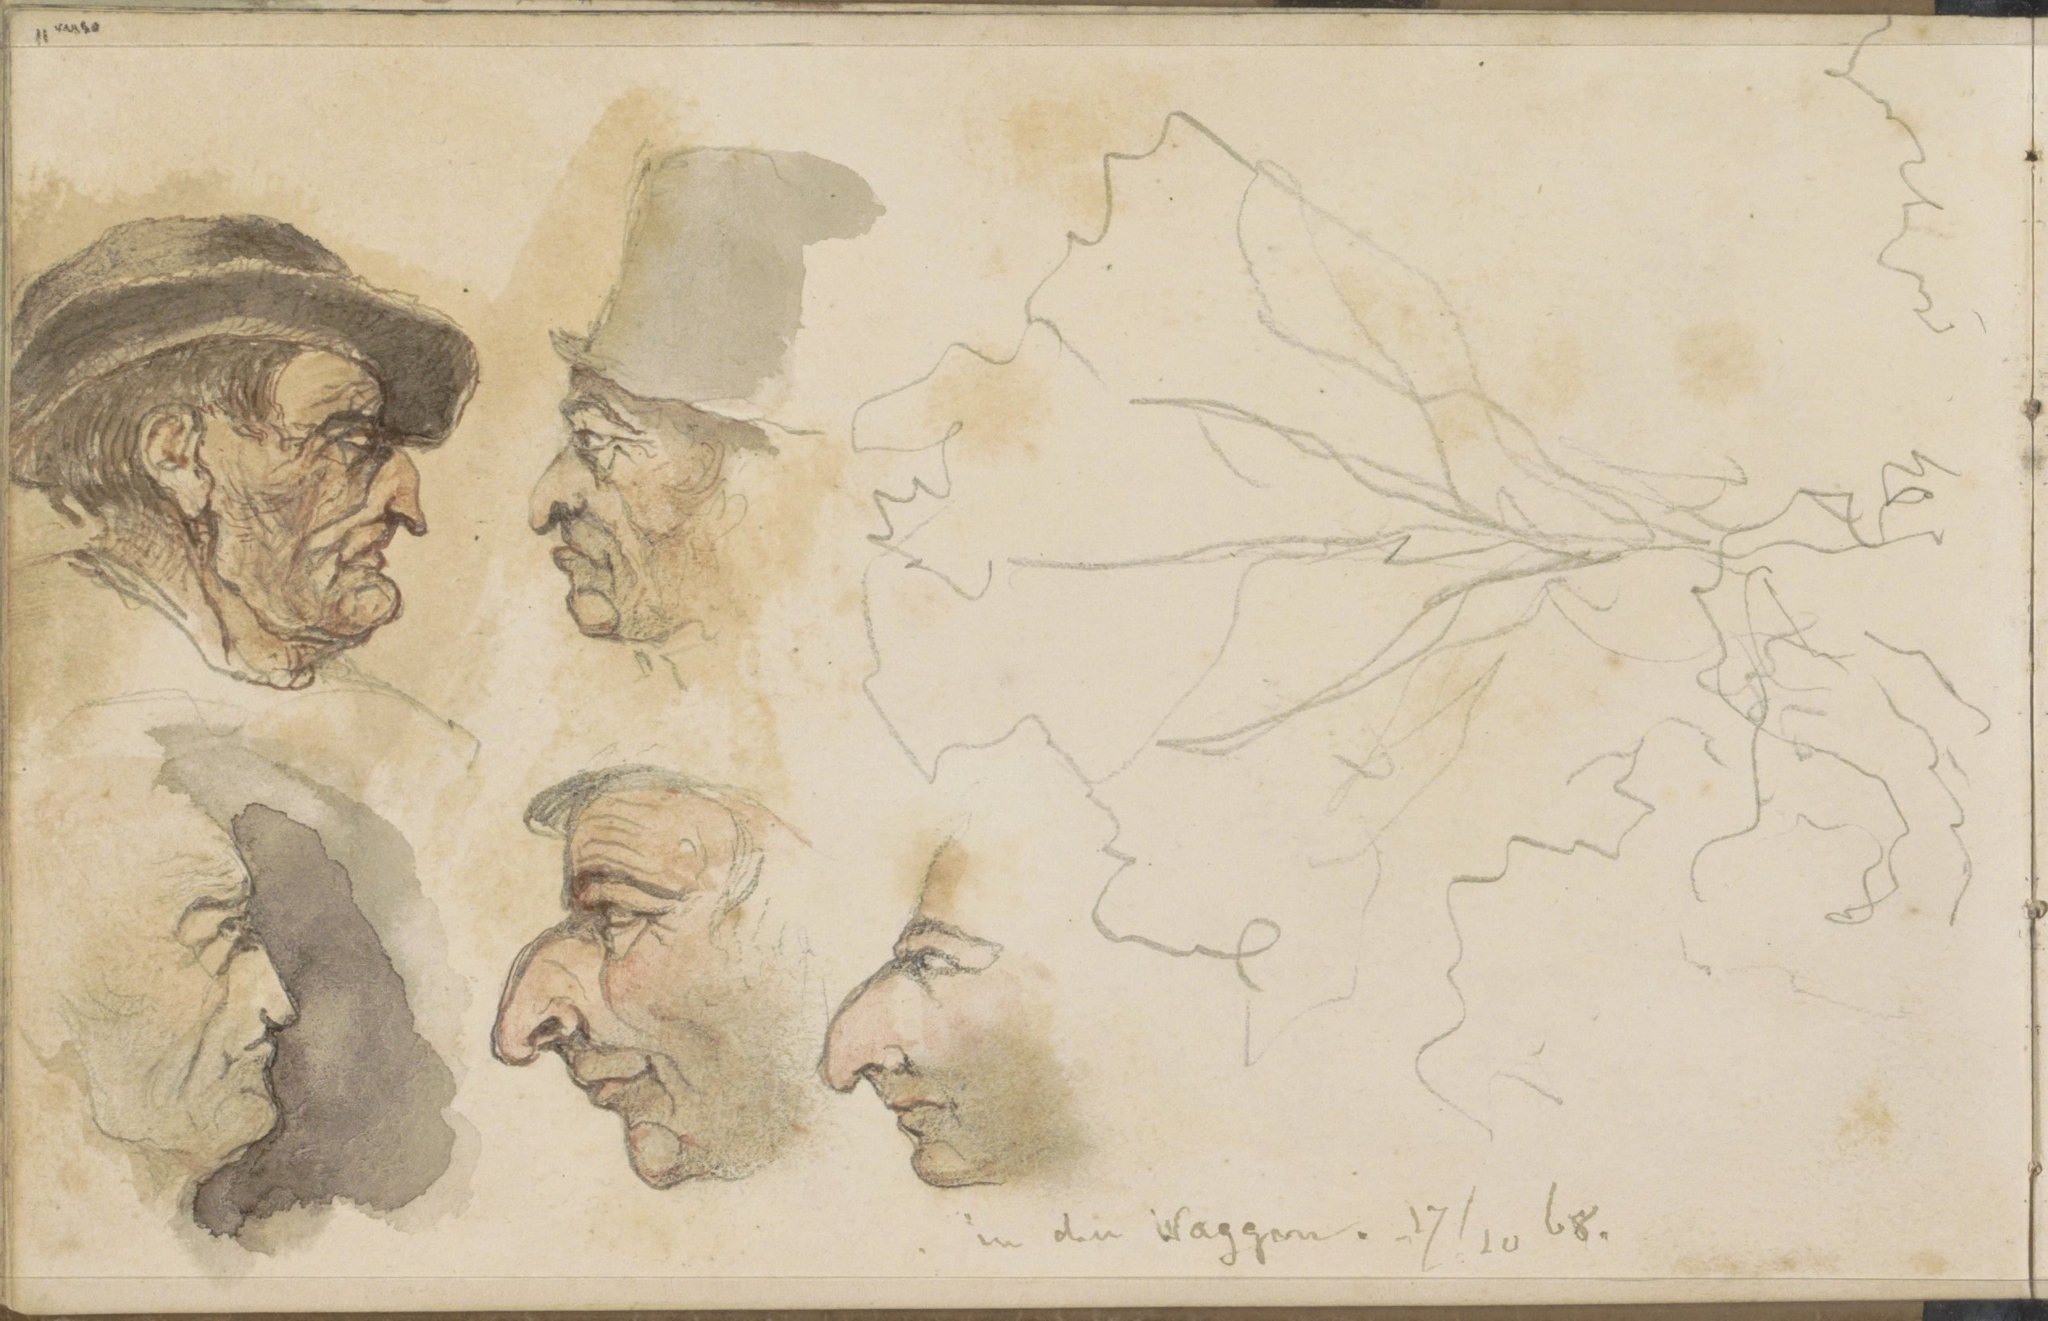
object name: sketchbook leaf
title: Koppen van mannen met haakneuzen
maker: johannes tavenraat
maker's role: draughtsman, painter, print maker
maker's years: 1809-1881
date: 1810-1868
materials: ink, paper, pencil, watercolor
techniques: brush, pen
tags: head (human), adult man, head-gear: hat (+ men's clothes)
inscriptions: date and inscription: ‘in den wagg[...] 17/10 68.’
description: Tevens een studie van een boom. Blad 11 verso uit een schetsboek met 48 bladen.